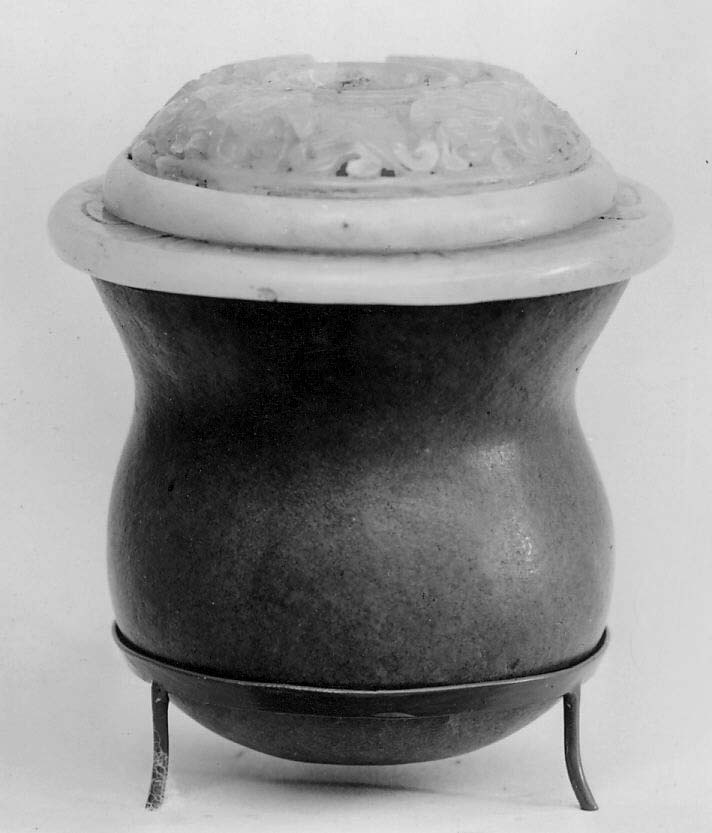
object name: cricket cage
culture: chinese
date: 1701-1900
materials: jade